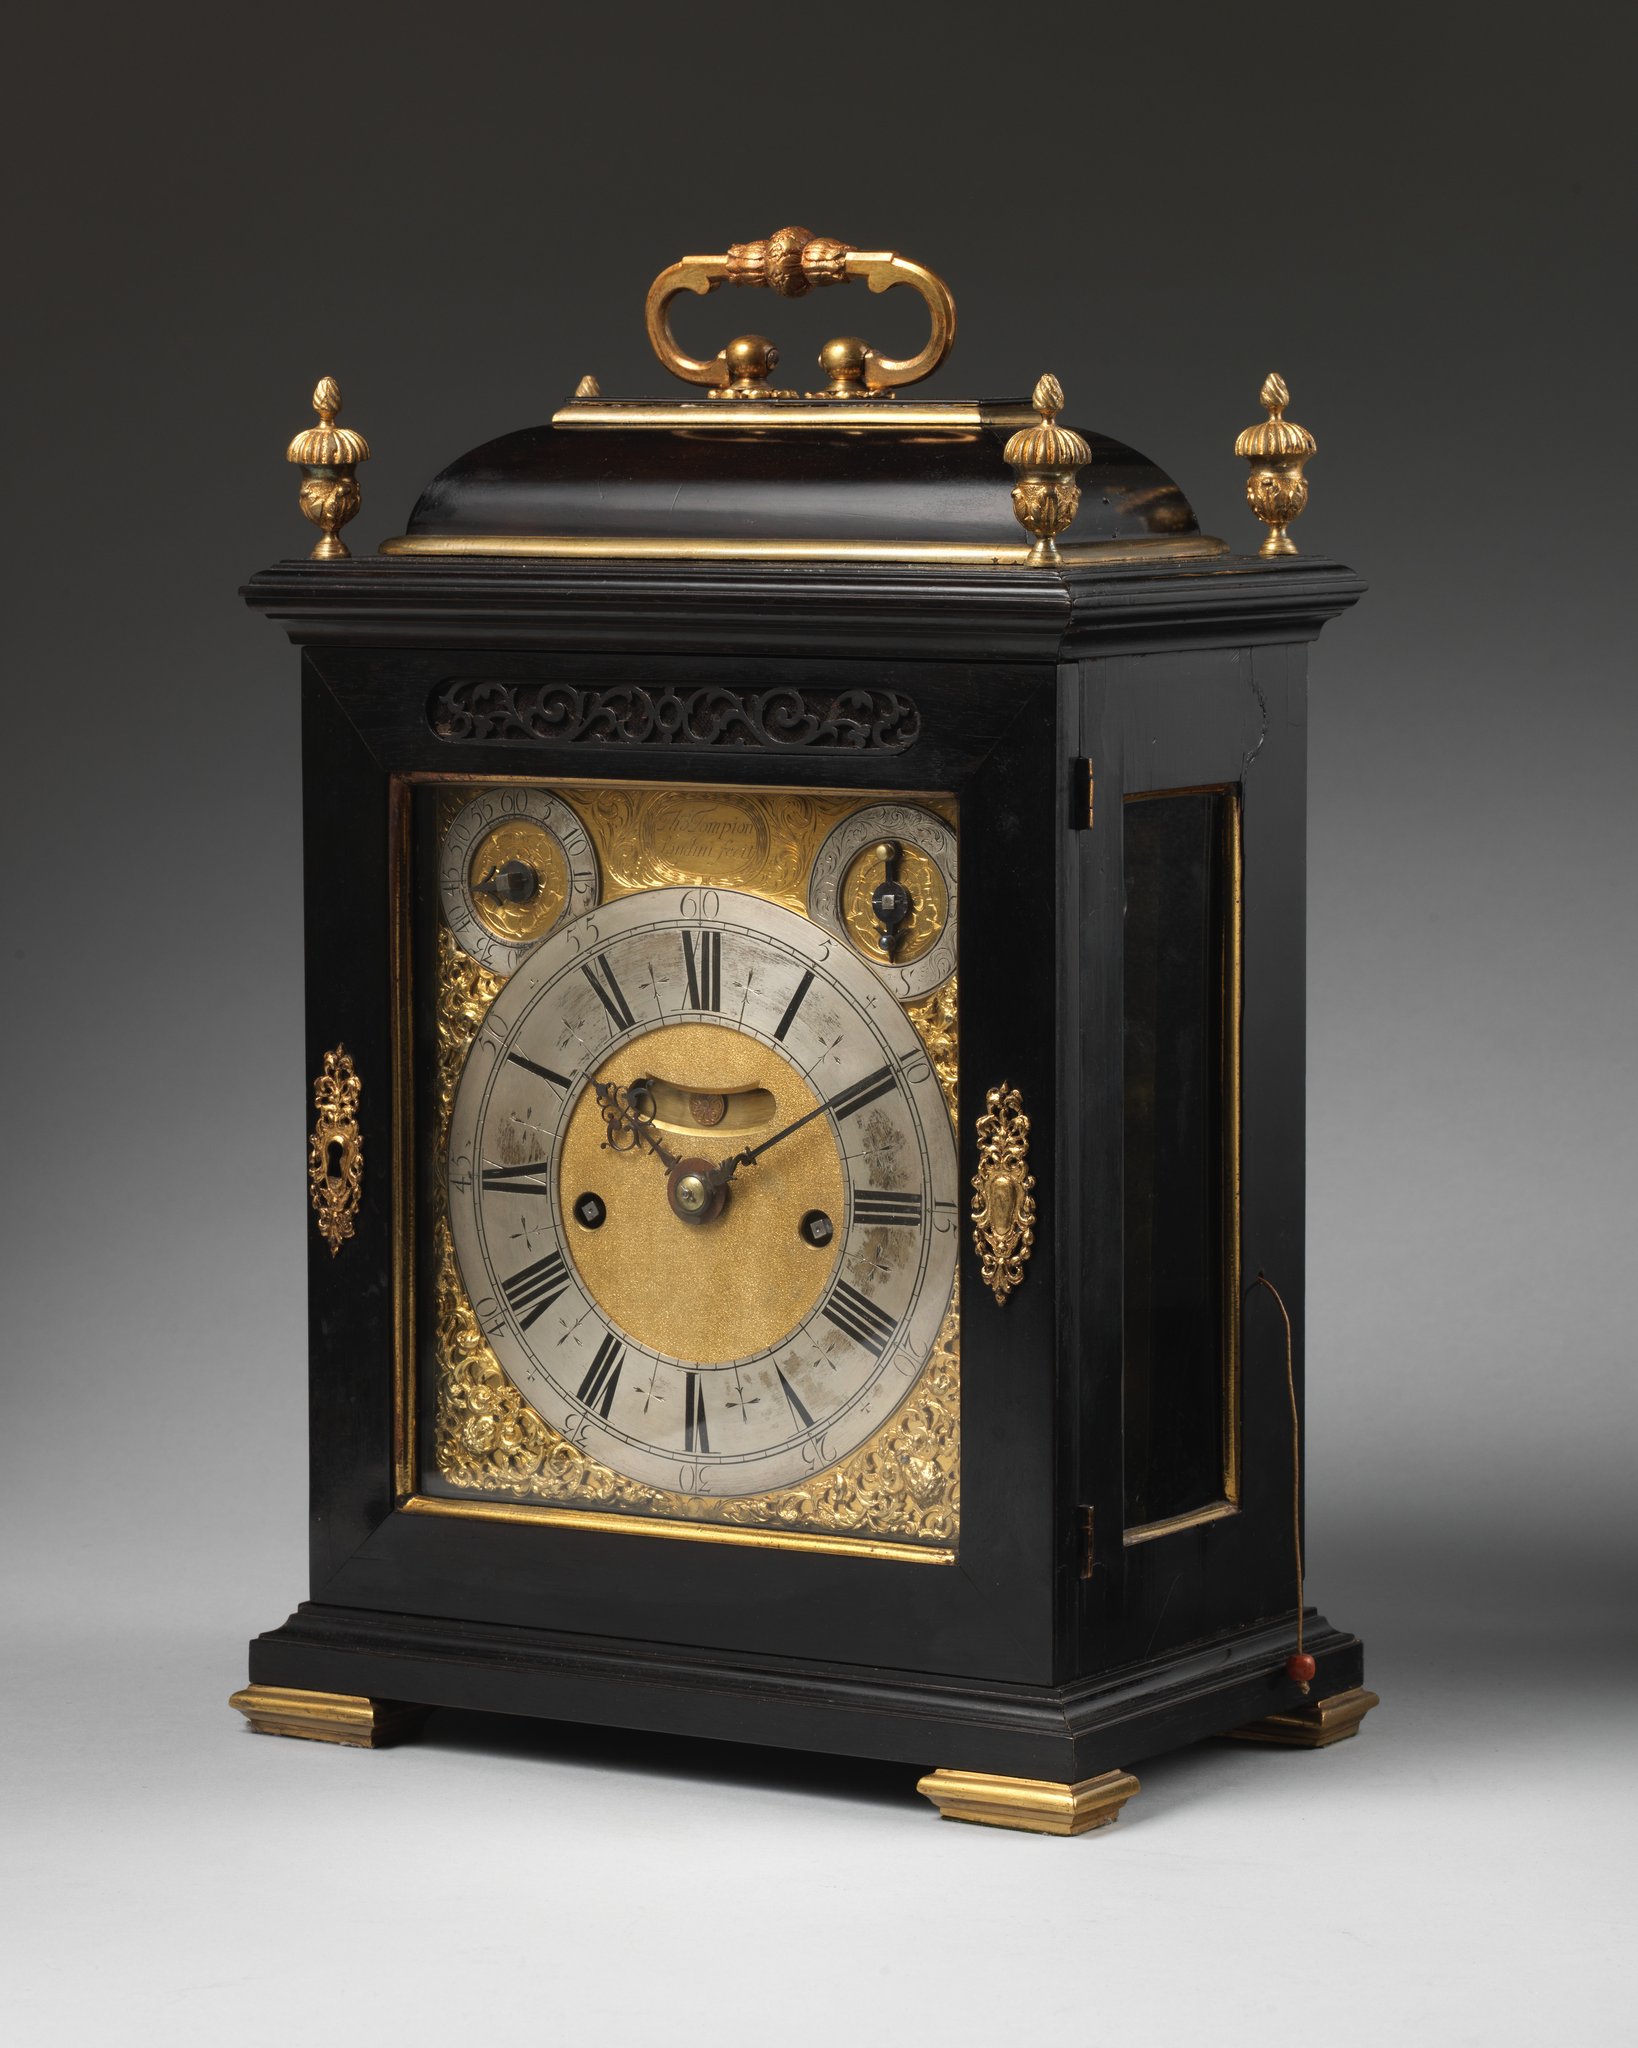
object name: bracket clock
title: Balloon bracket clock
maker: savory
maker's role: maker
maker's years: 1750-1850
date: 1790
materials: wood